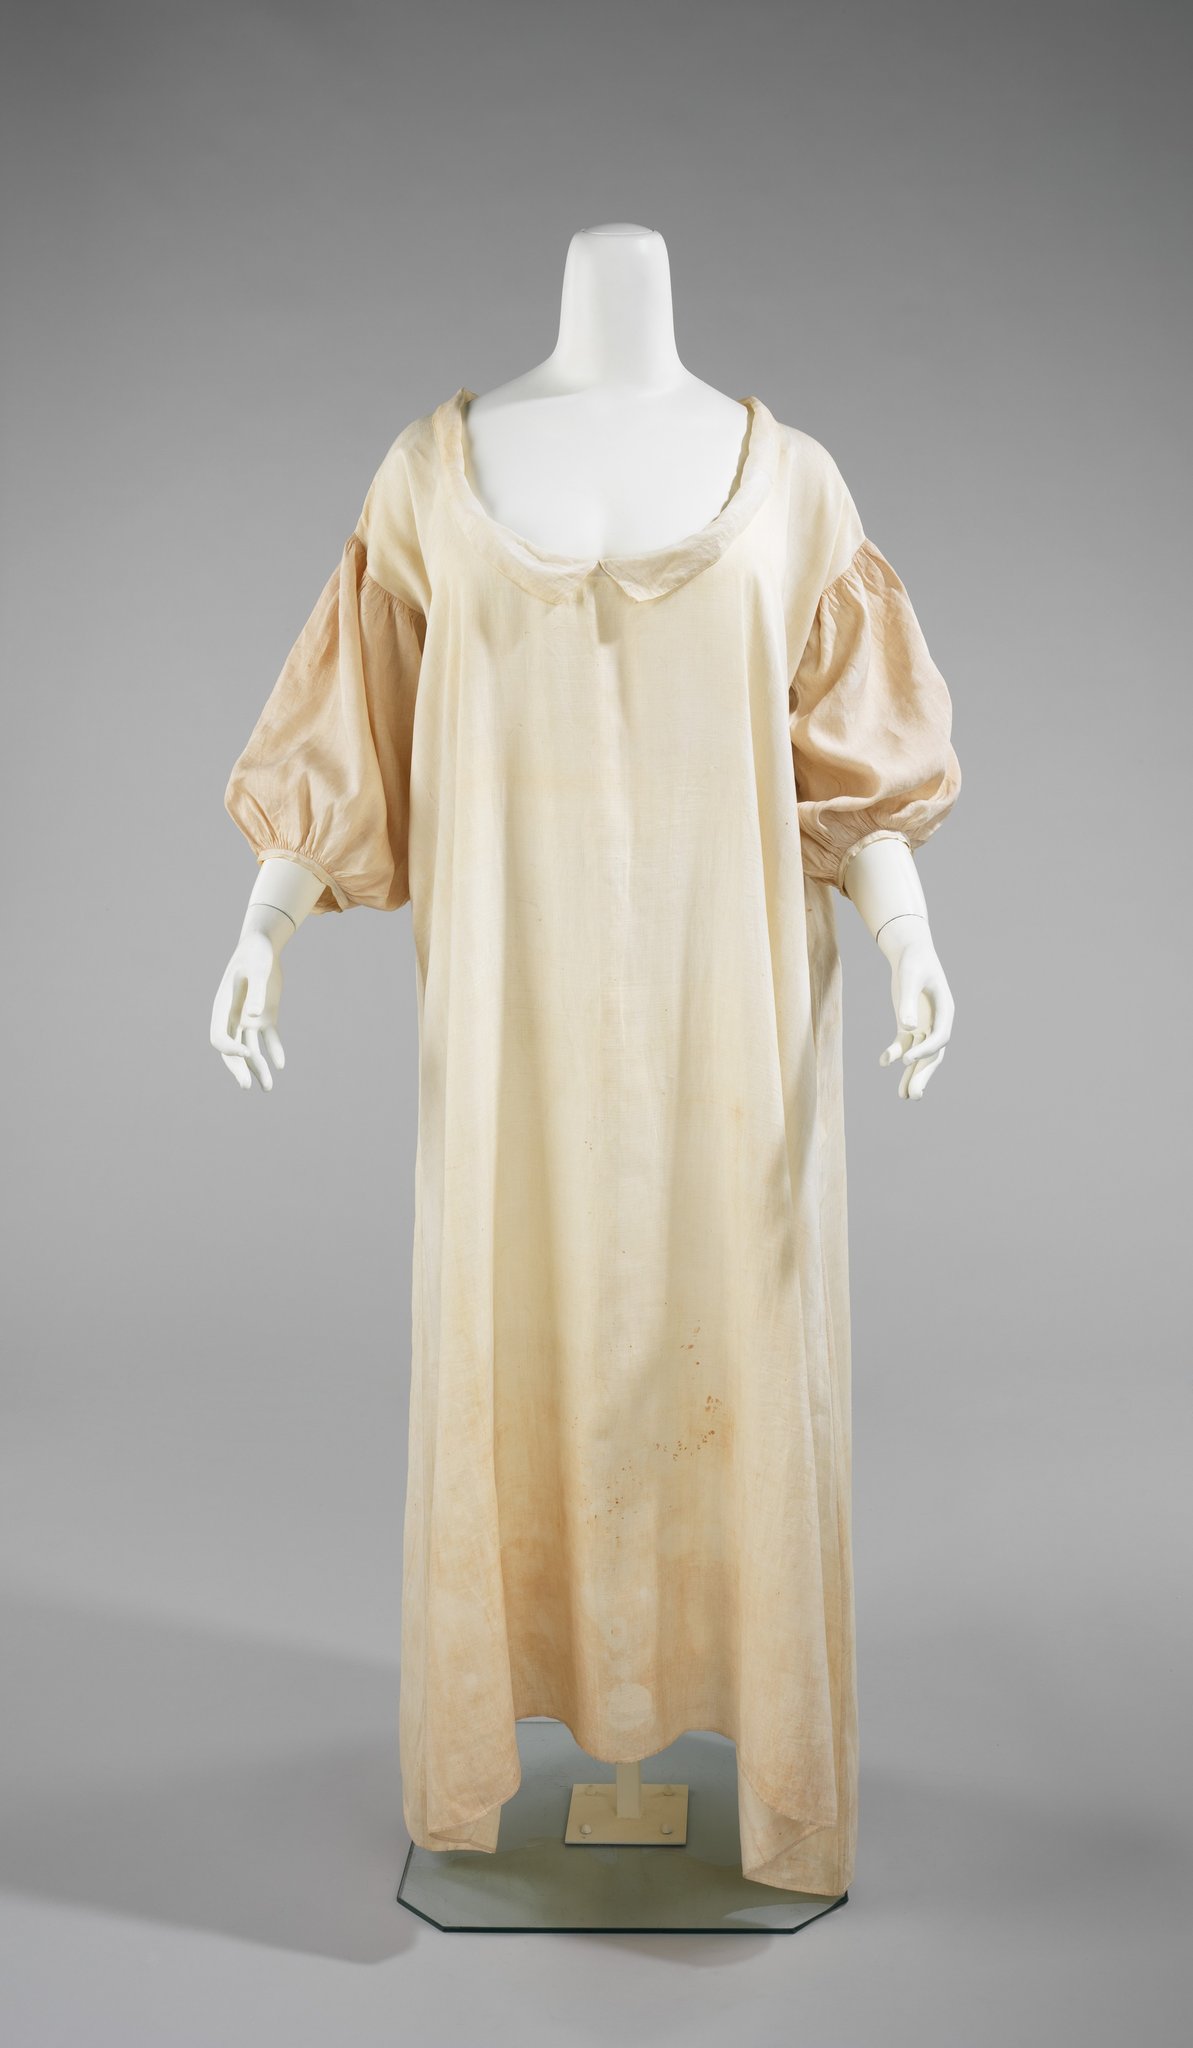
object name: chemise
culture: american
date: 1822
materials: linen